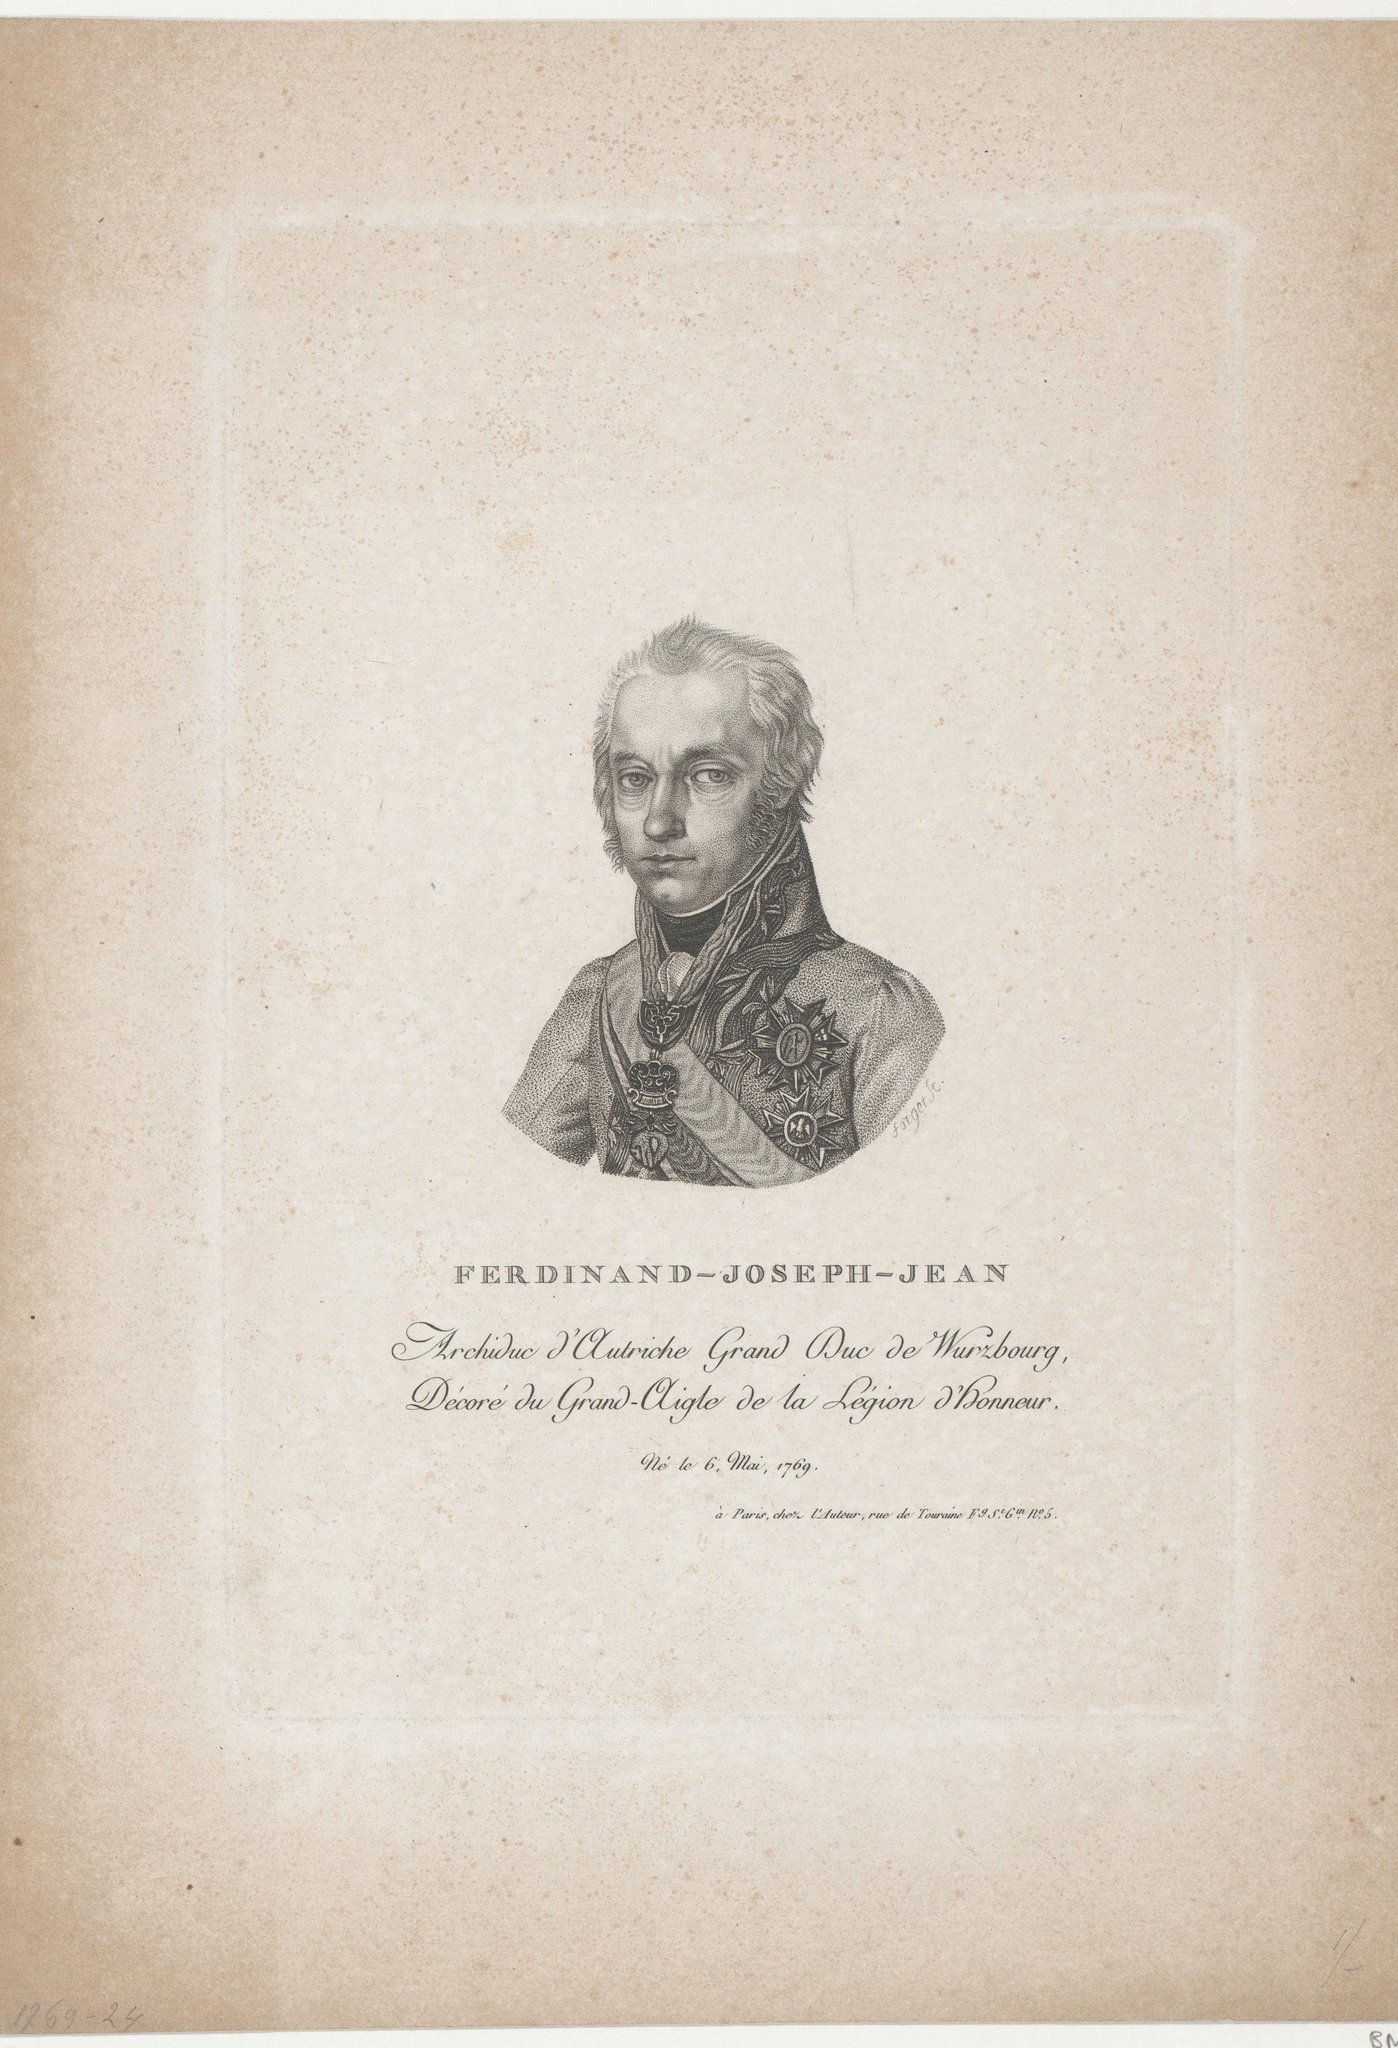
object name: print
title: Portretten van leden van het Legioen van Eer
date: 1810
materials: paper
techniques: etching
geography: paris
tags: ferdinand iii (groothertog van toscane), historical persons, decorations, honours (as symbols of the state, etc.)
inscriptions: collector's mark: Lugt 2228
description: Maakt deel uit van een serie portretten van leden van het Legioen van Eer getiteld 'Collection complète des portraits des Grands-Aigles et des Grands-Officiers de la Légion d'Honneur', uitgegeven in 1810 te Parijs door Mayer.